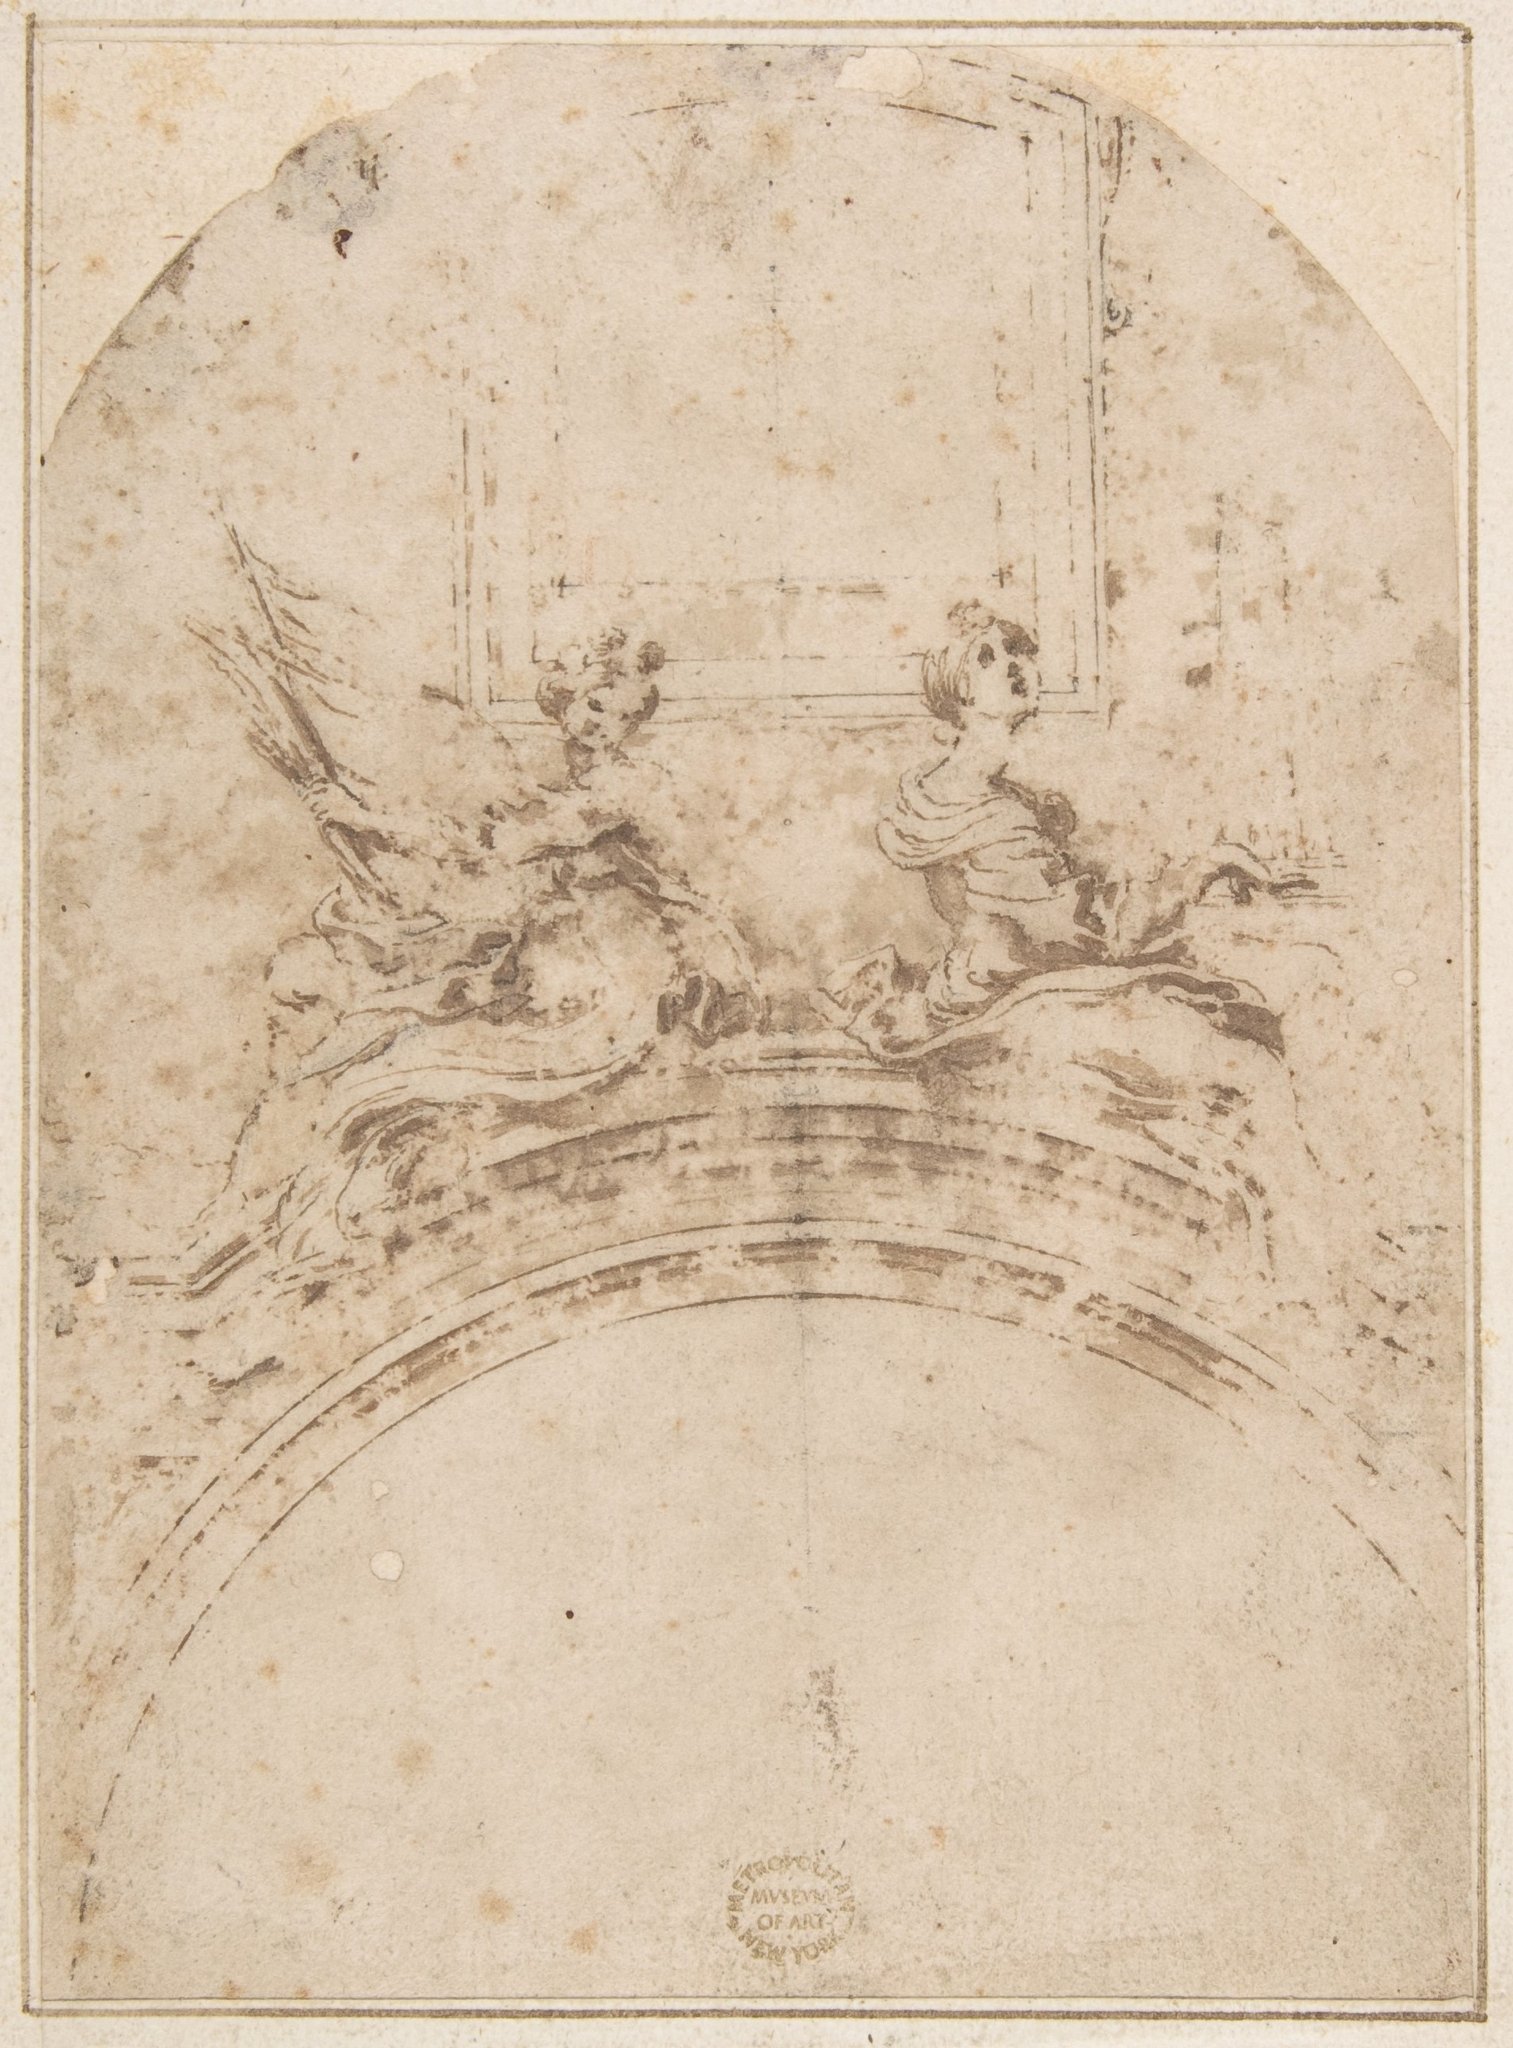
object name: drawing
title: Seated Figures of Saint Ursula and Saint Cecilia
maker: gian lorenzo bernini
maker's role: artist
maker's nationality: italian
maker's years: 1598-1680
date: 1598-1680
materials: ink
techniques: brush, pen, wash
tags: saints